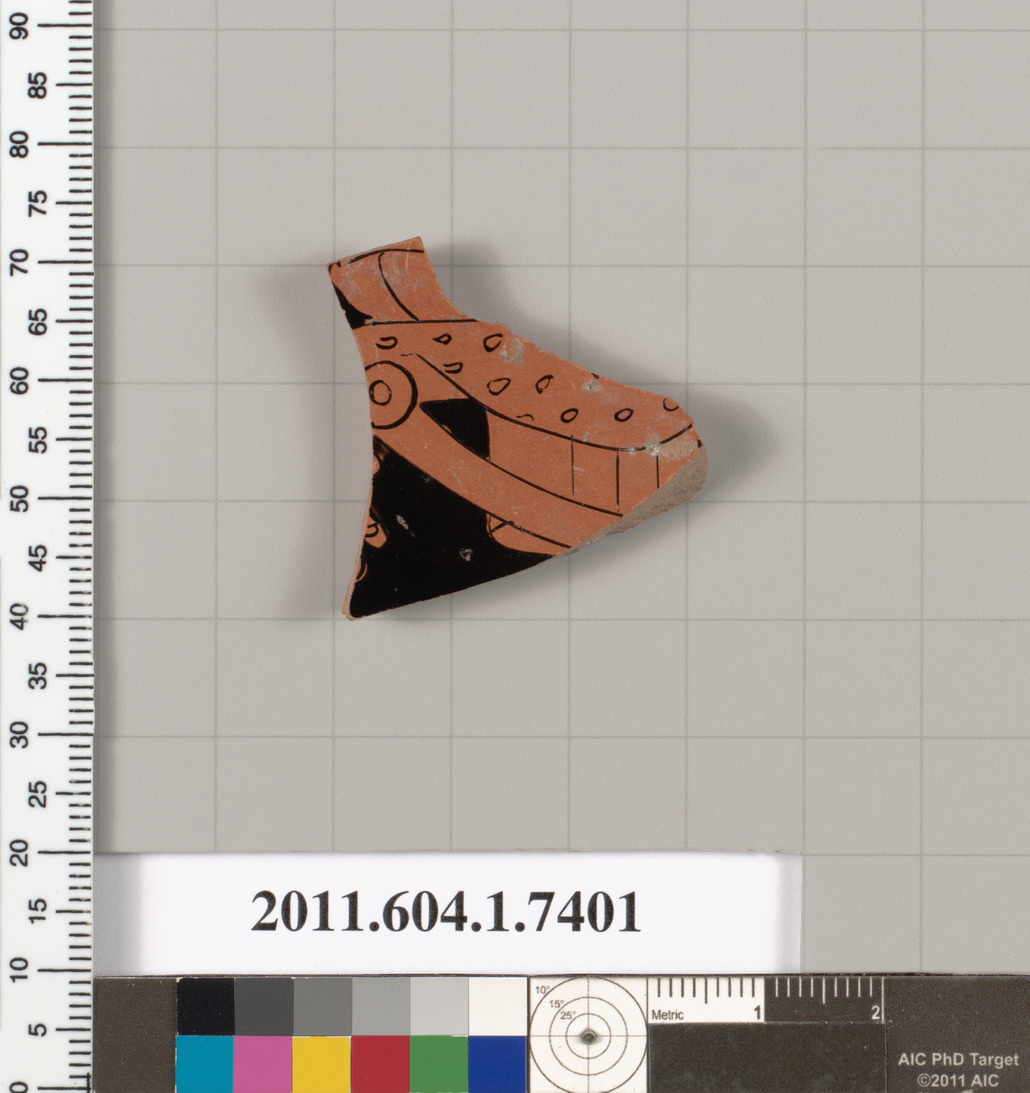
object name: kylix fragment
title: Terracotta fragment of a kylix (drinking cup)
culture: greek, attic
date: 500-480 BCE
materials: terracotta